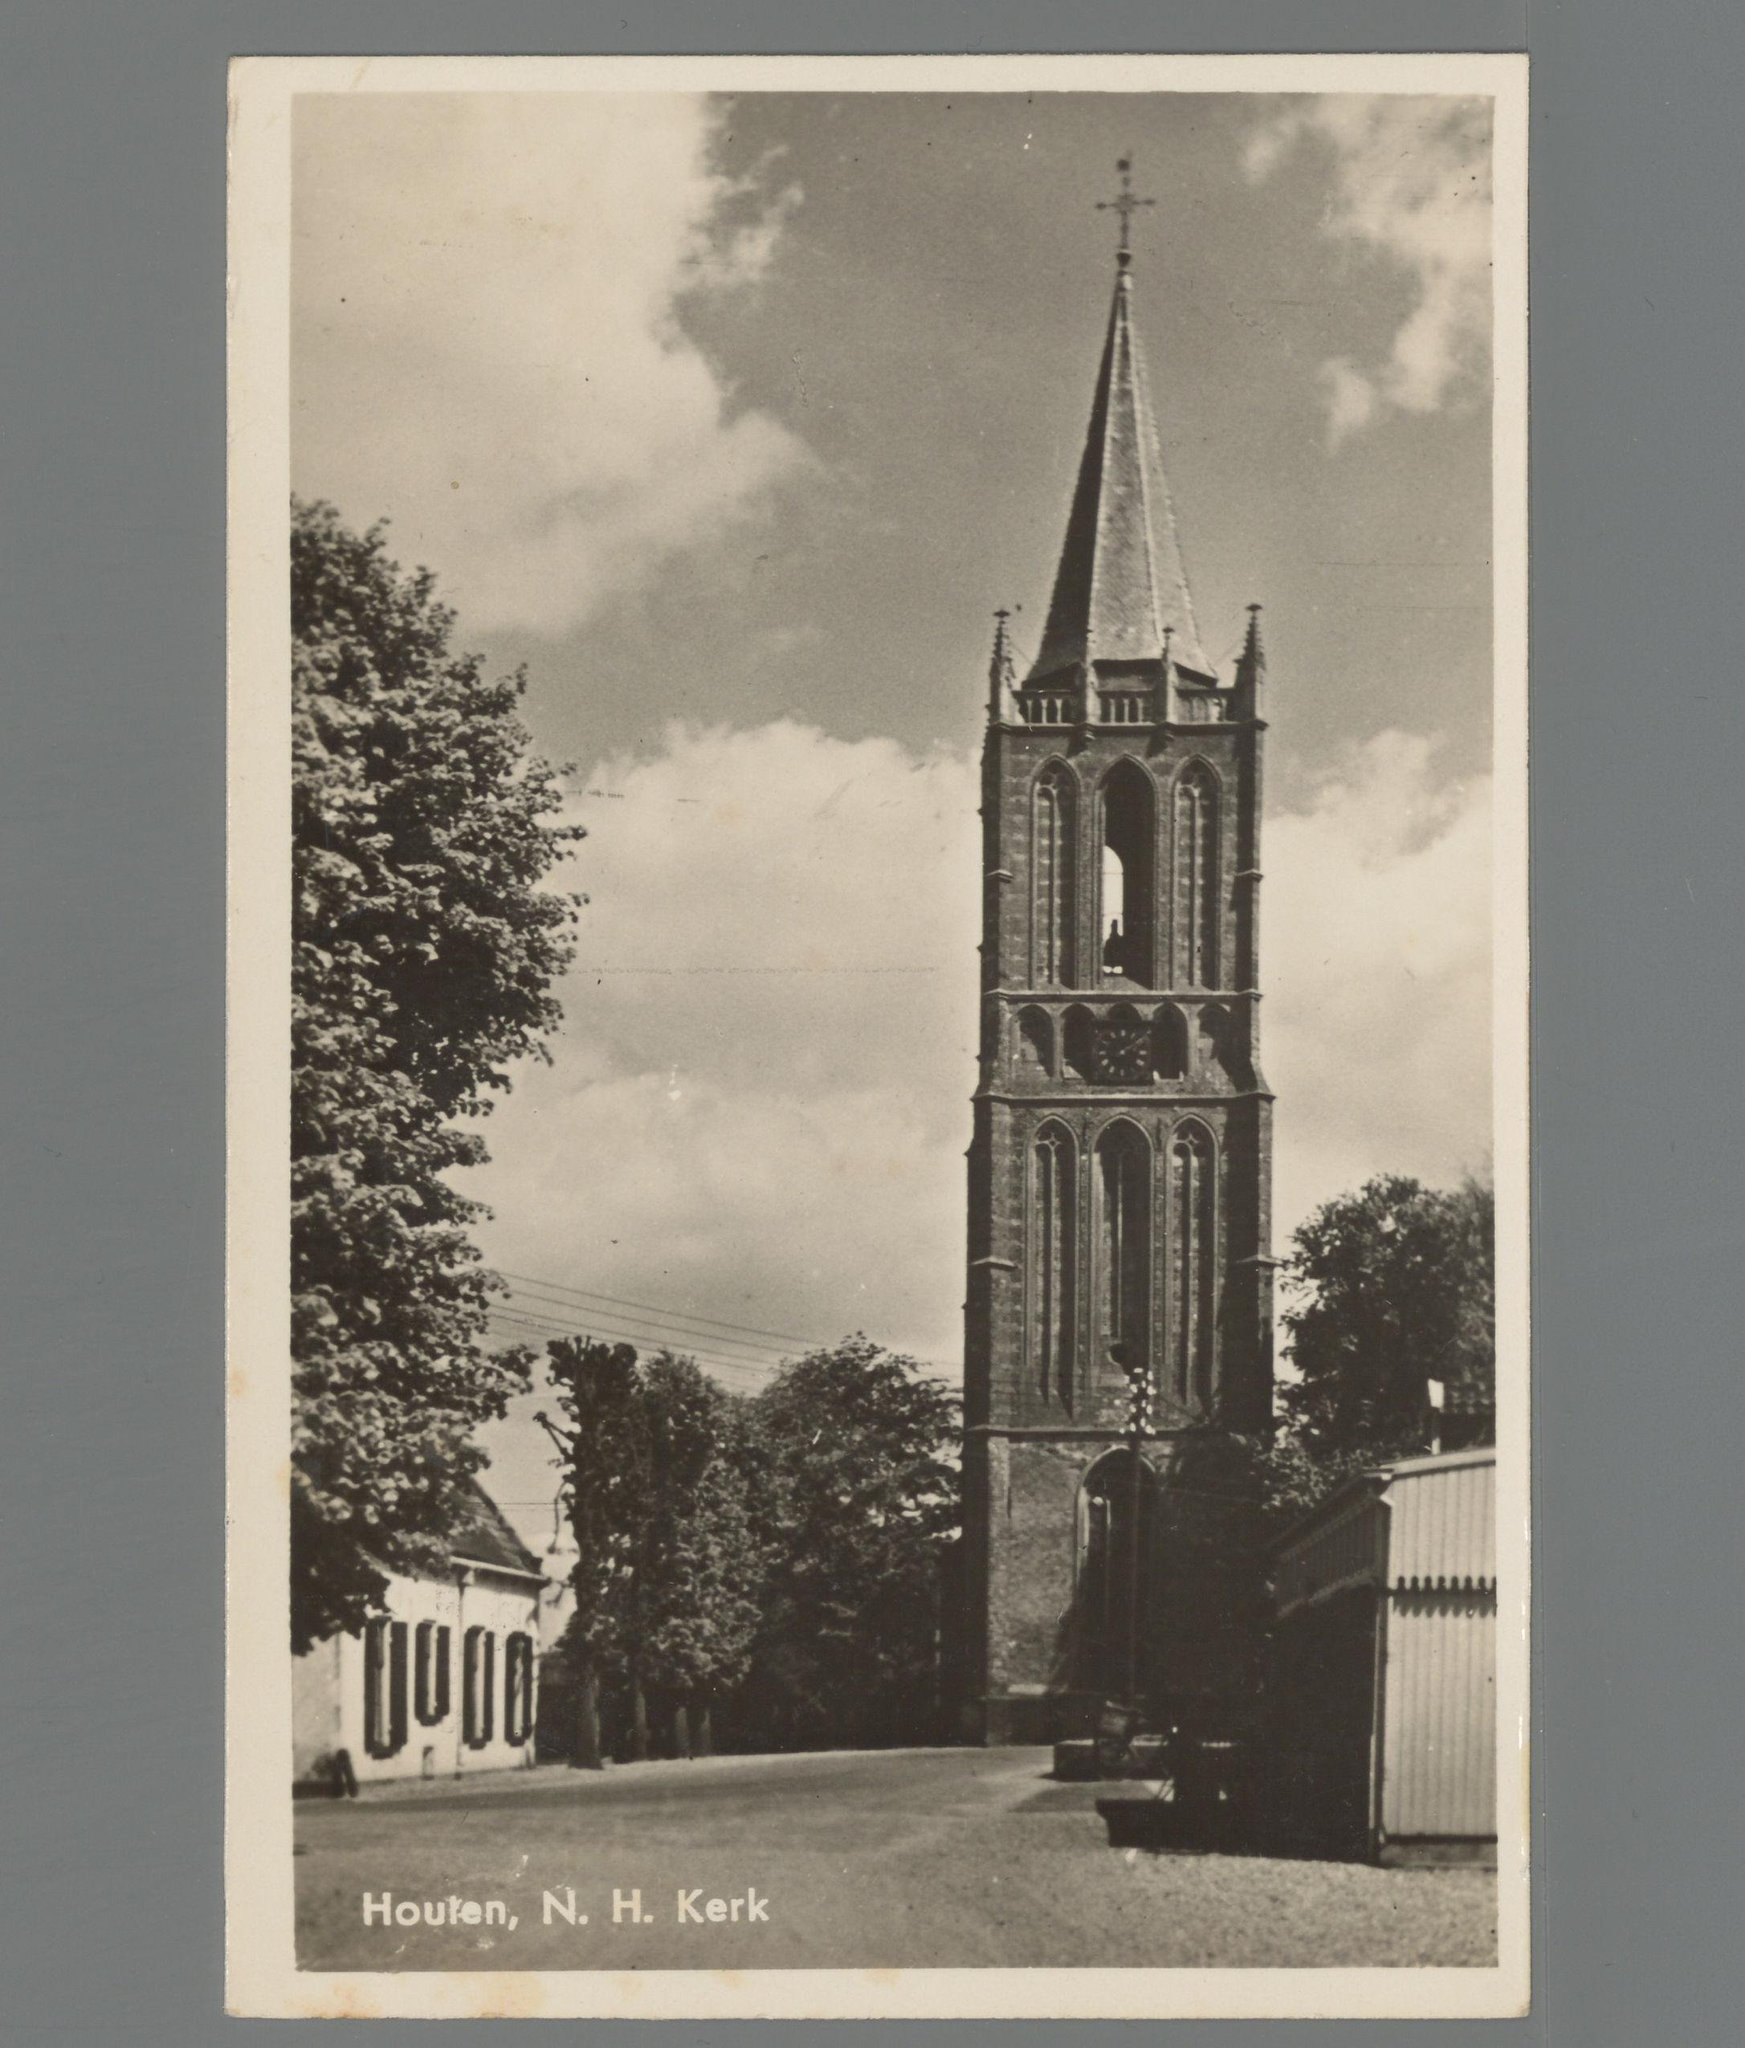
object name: photograph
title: Houten, N. H. Kerk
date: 1906-1939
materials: paper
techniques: gelatin silver print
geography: arnhem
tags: church (exterior)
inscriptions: date